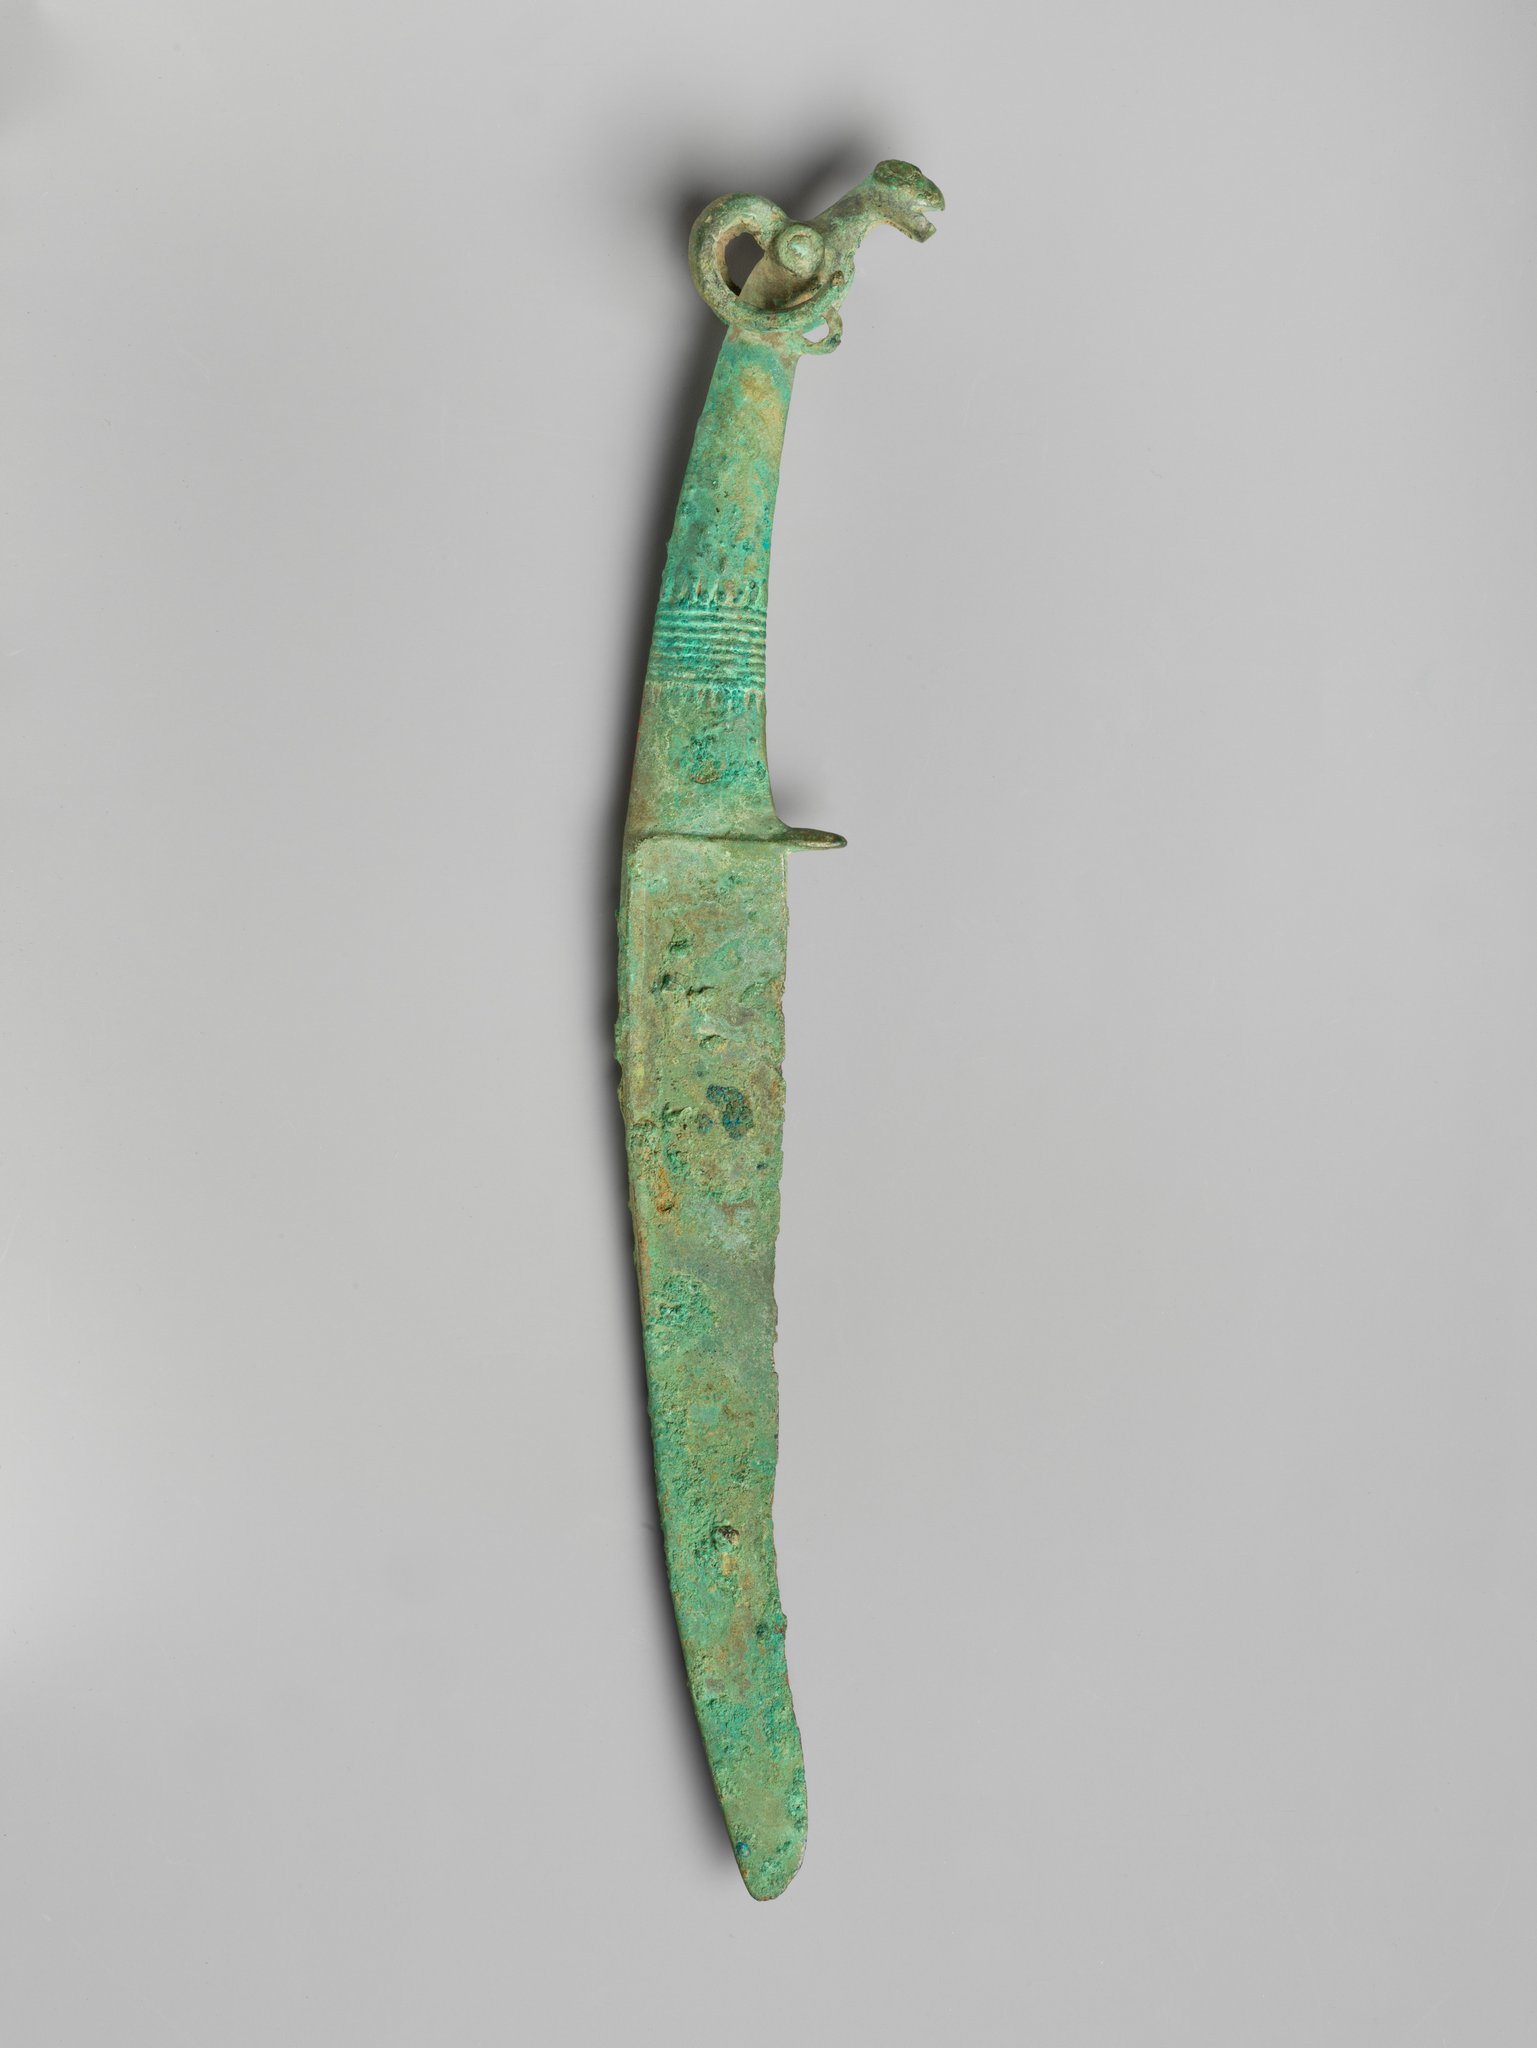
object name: knife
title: Knife with Ram's Head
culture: chinese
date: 1200-1001 BCE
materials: bronze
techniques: inlay